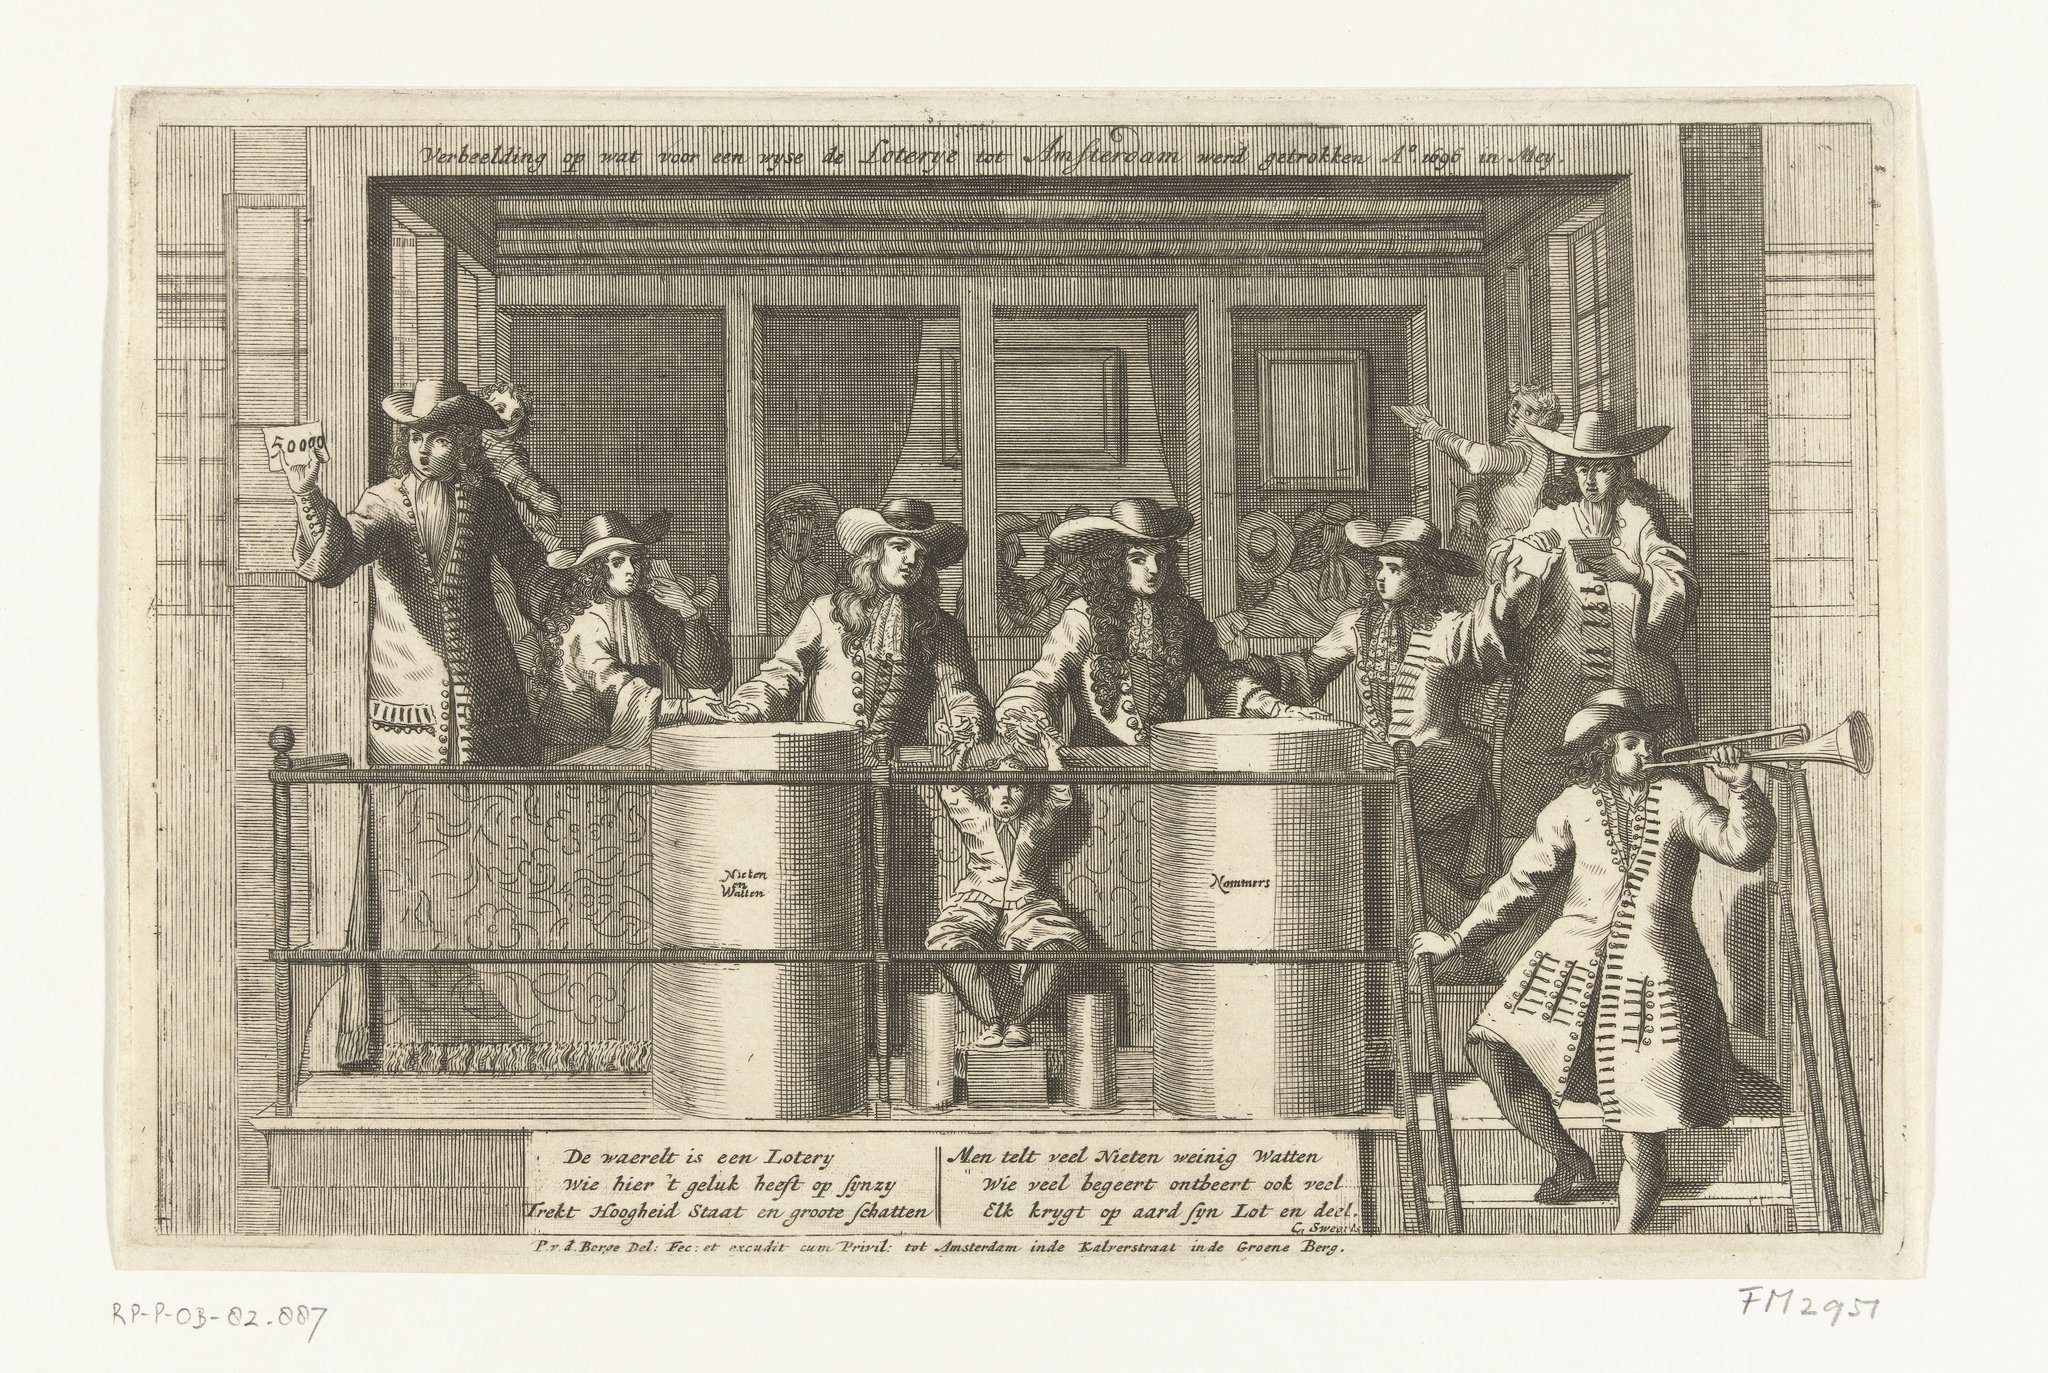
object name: print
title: Trekking van de loterij te Amsterdam, 1696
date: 1696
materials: paper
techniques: engraving, etching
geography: amsterdam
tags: raffle, lottery, amsterdam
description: Trekking van de loterij te Amsterdam, mei 1696. Op een open gallerij staan twee grote vaten. Rechts de Nieten en Watten, links de Nommers. Een jongetje trekt uit elk een lot en geeft deze naar achteren door. Hier worden de winnaars opgeschreven en uitgeroepen. Onder de voorstelling een vers in twee kolommen van elk drie regels op de wereld als lotterij.